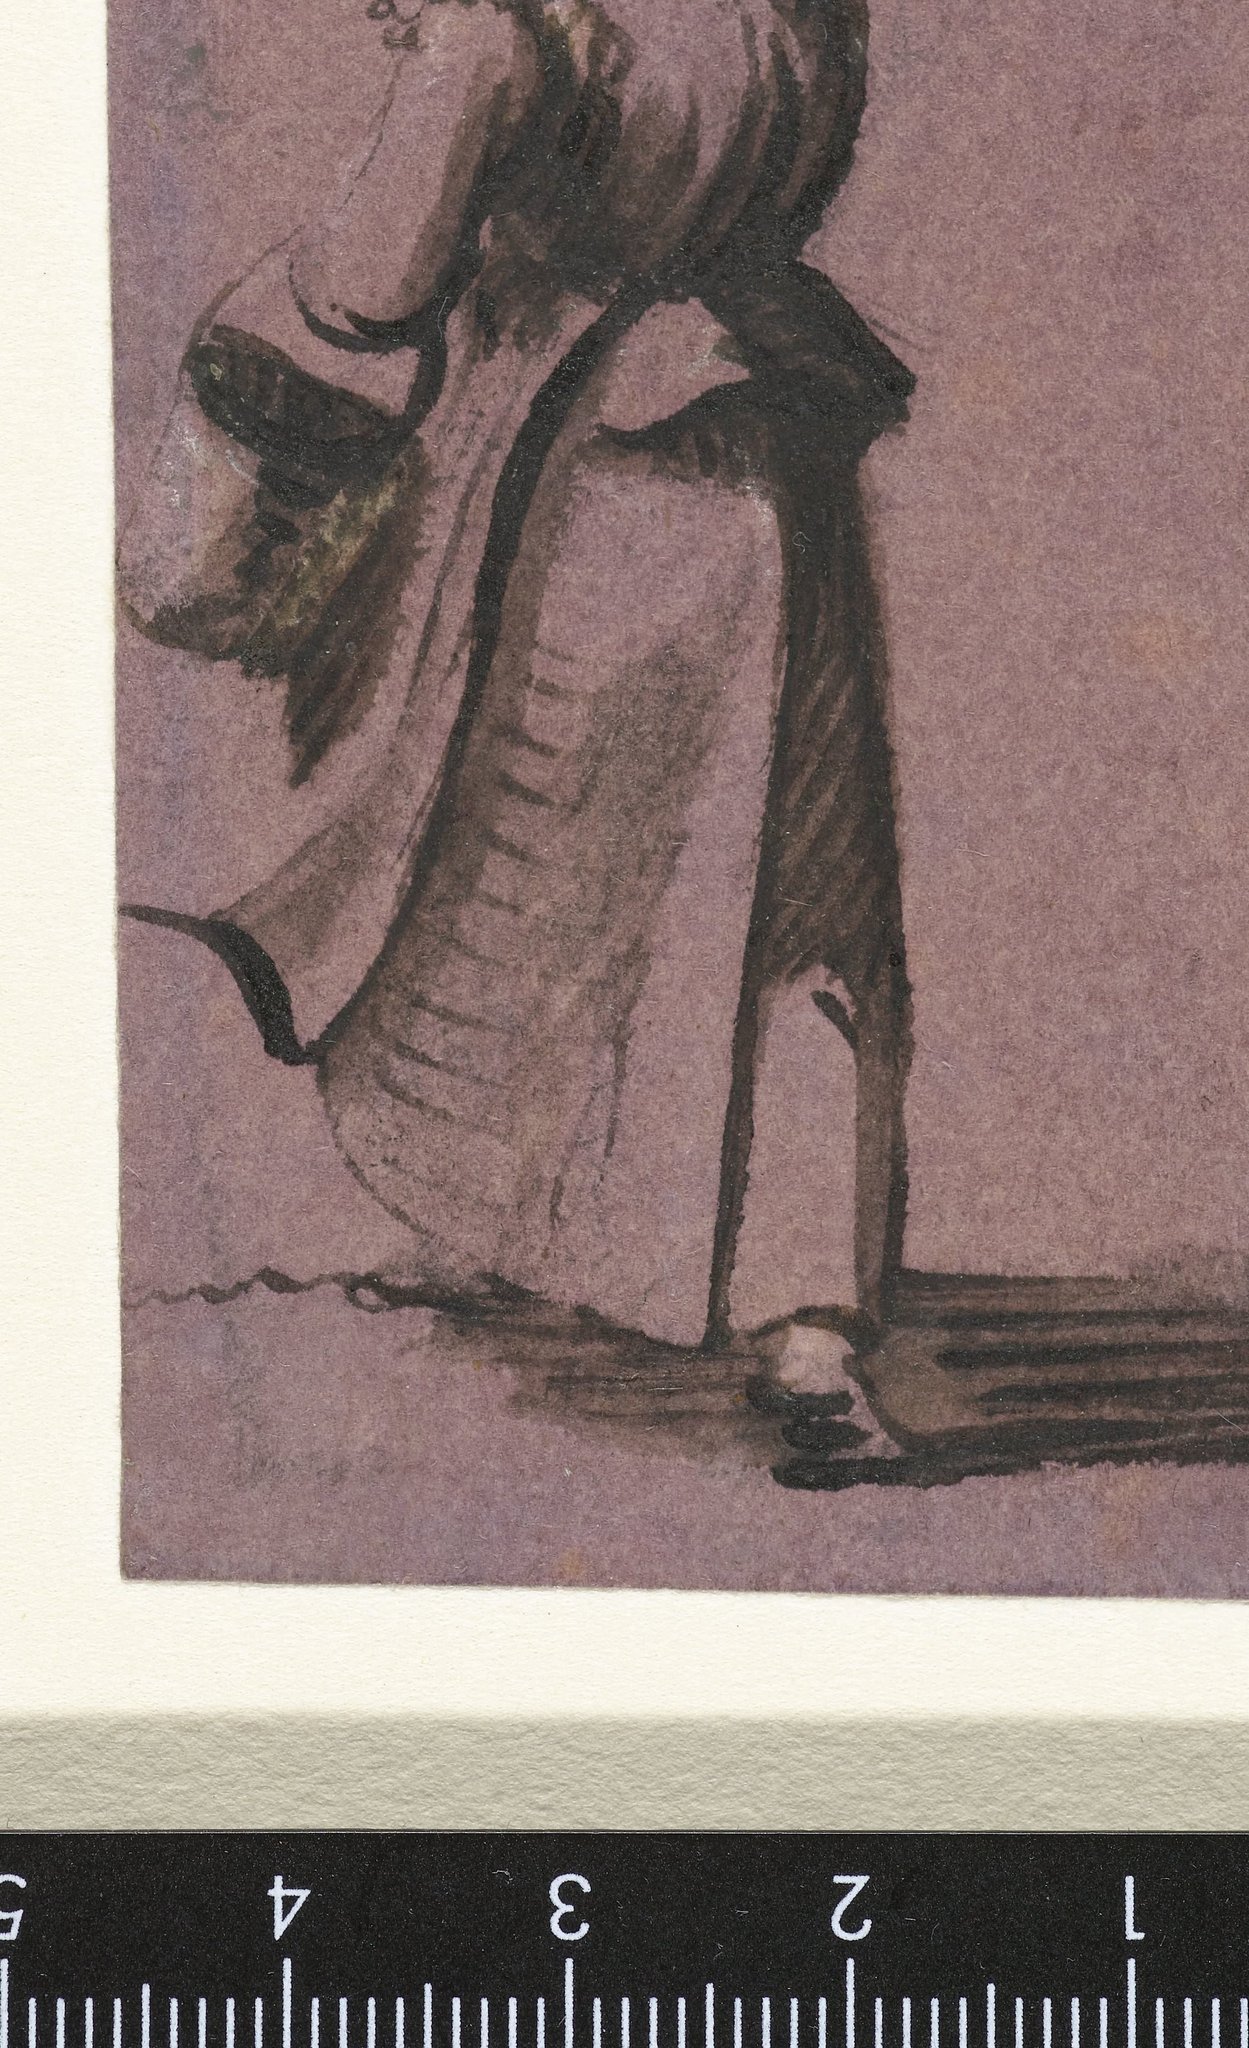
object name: drawing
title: Vrouw naar links lopend, van achteren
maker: harmen ter borch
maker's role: draughtsman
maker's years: 1638-1677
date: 1651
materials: ink, paper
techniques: brush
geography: zwolle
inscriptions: number: ‘239’, annotation: ‘Harman ter Borch 1651’